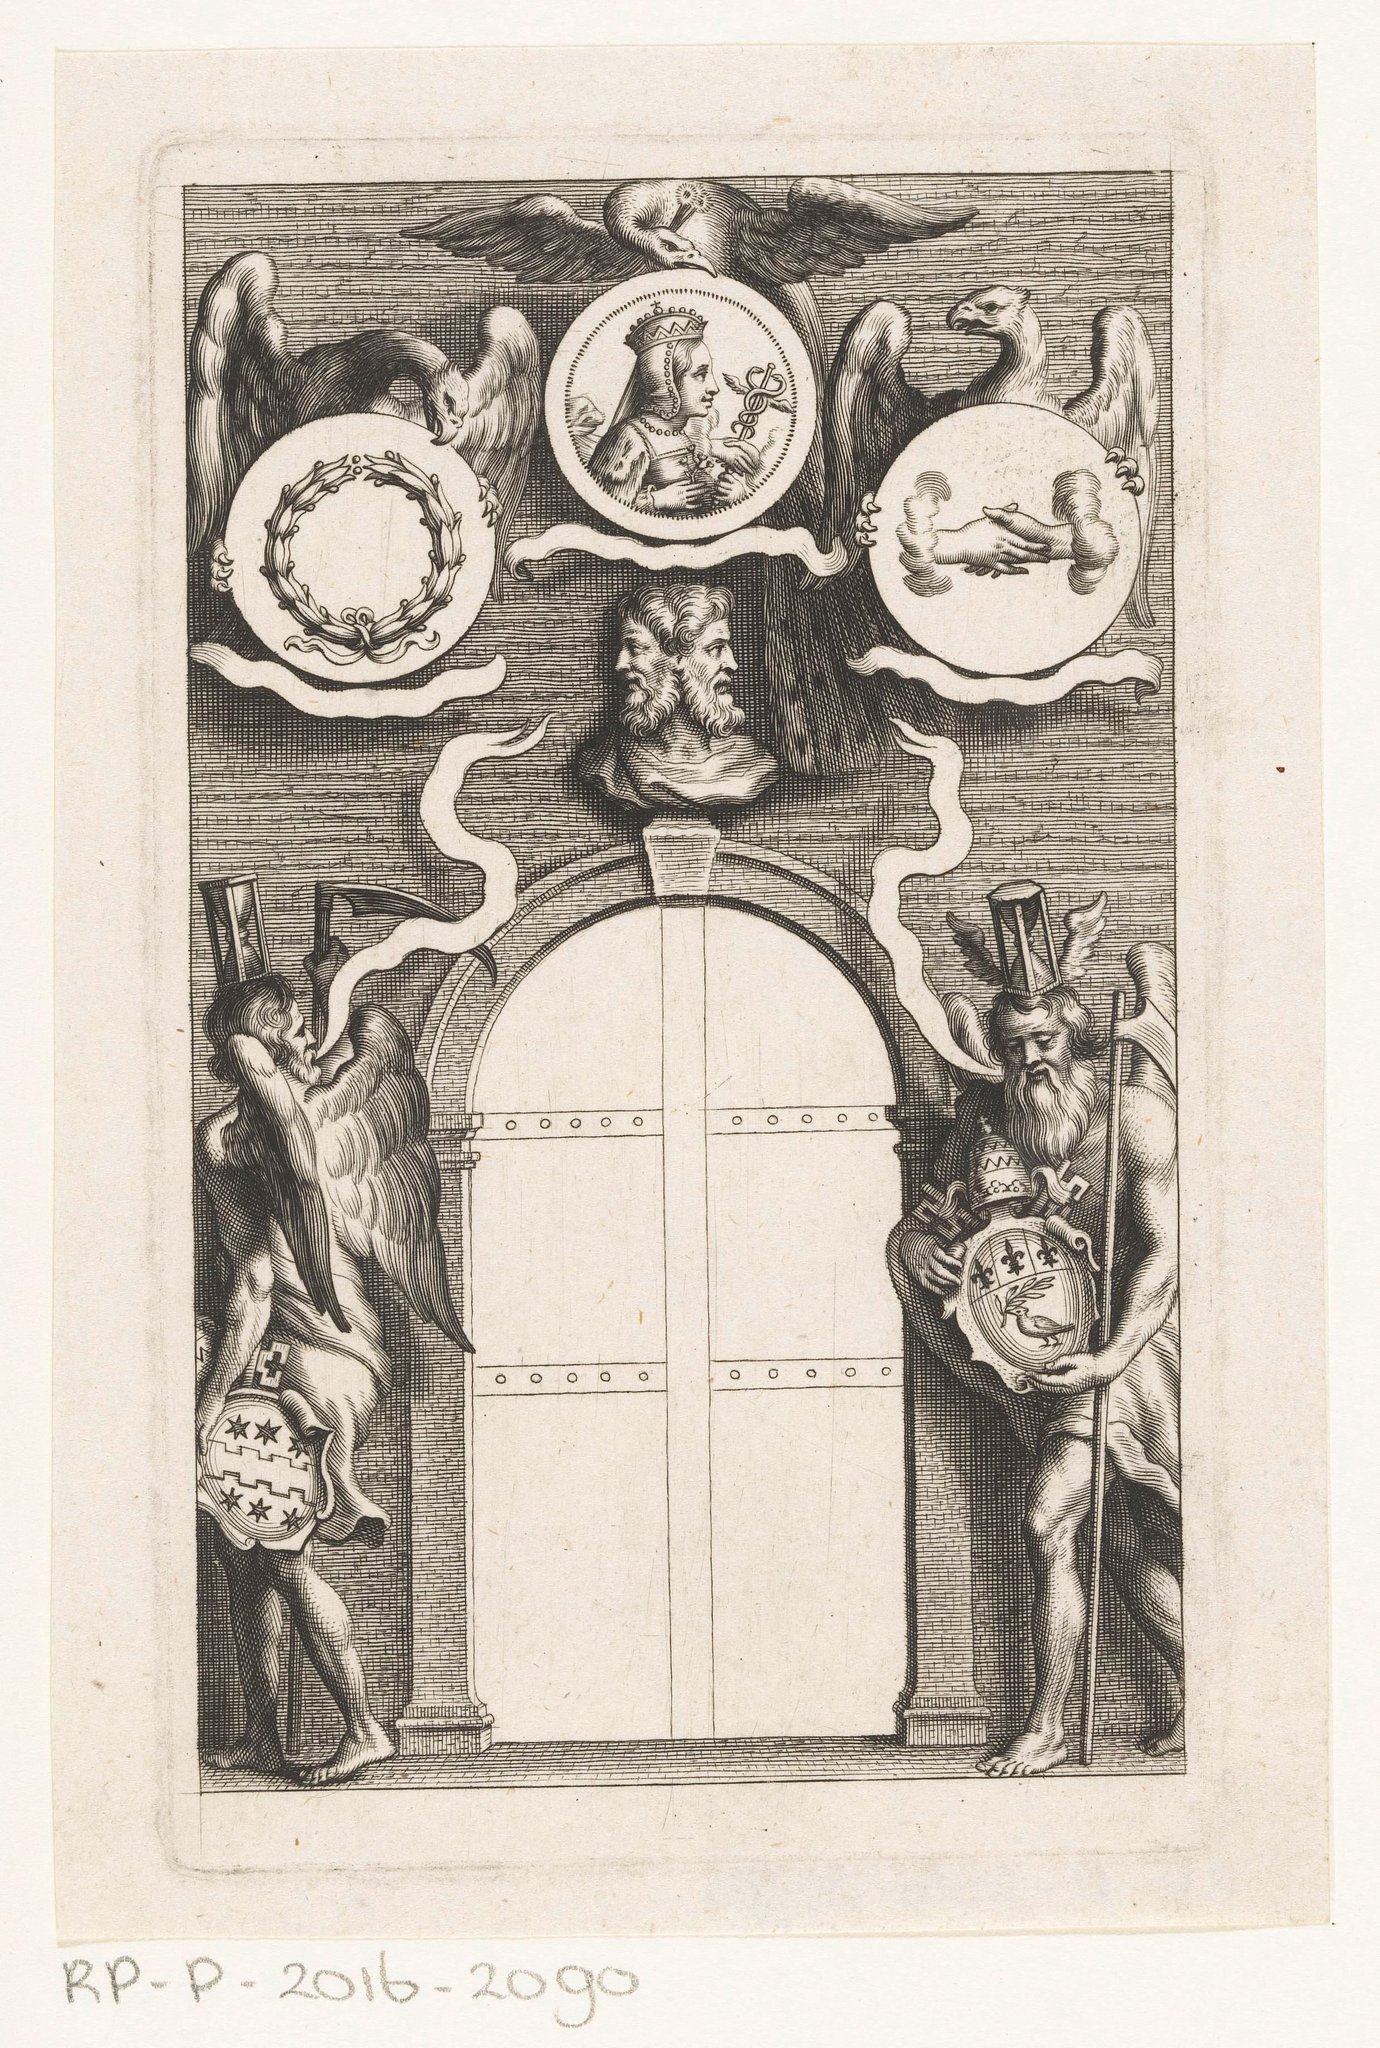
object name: print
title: Proefdruk van titelpagina voor: Jean Jacques Chiflet, Recueil des traittez de paix, 1645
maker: cornelis galle (ii)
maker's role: print maker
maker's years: 1615-1678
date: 1643-1645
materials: paper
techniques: engraving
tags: rome, innocentius x, clemens viii, monumental door, porch, 'aediculum', predatory birds: eagle, ornament ~ medallion, ornamental birds: peacock, father time, man with wings and scythe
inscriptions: collector's mark: Lugt 240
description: Boven een poort een Januskop en een pauw en twee adelaars met ieder een rond medaillon met een lauwerkrans, een vrouwelijke heerser (Margaretha van Oostenrijk?) en twee elkaar schuddende handen. Vader Tijd staat zowel links als rechts van de poort (de Heilige Deur?) met de pauselijke wapenschilden van Clemens VIII en Innocentius X.